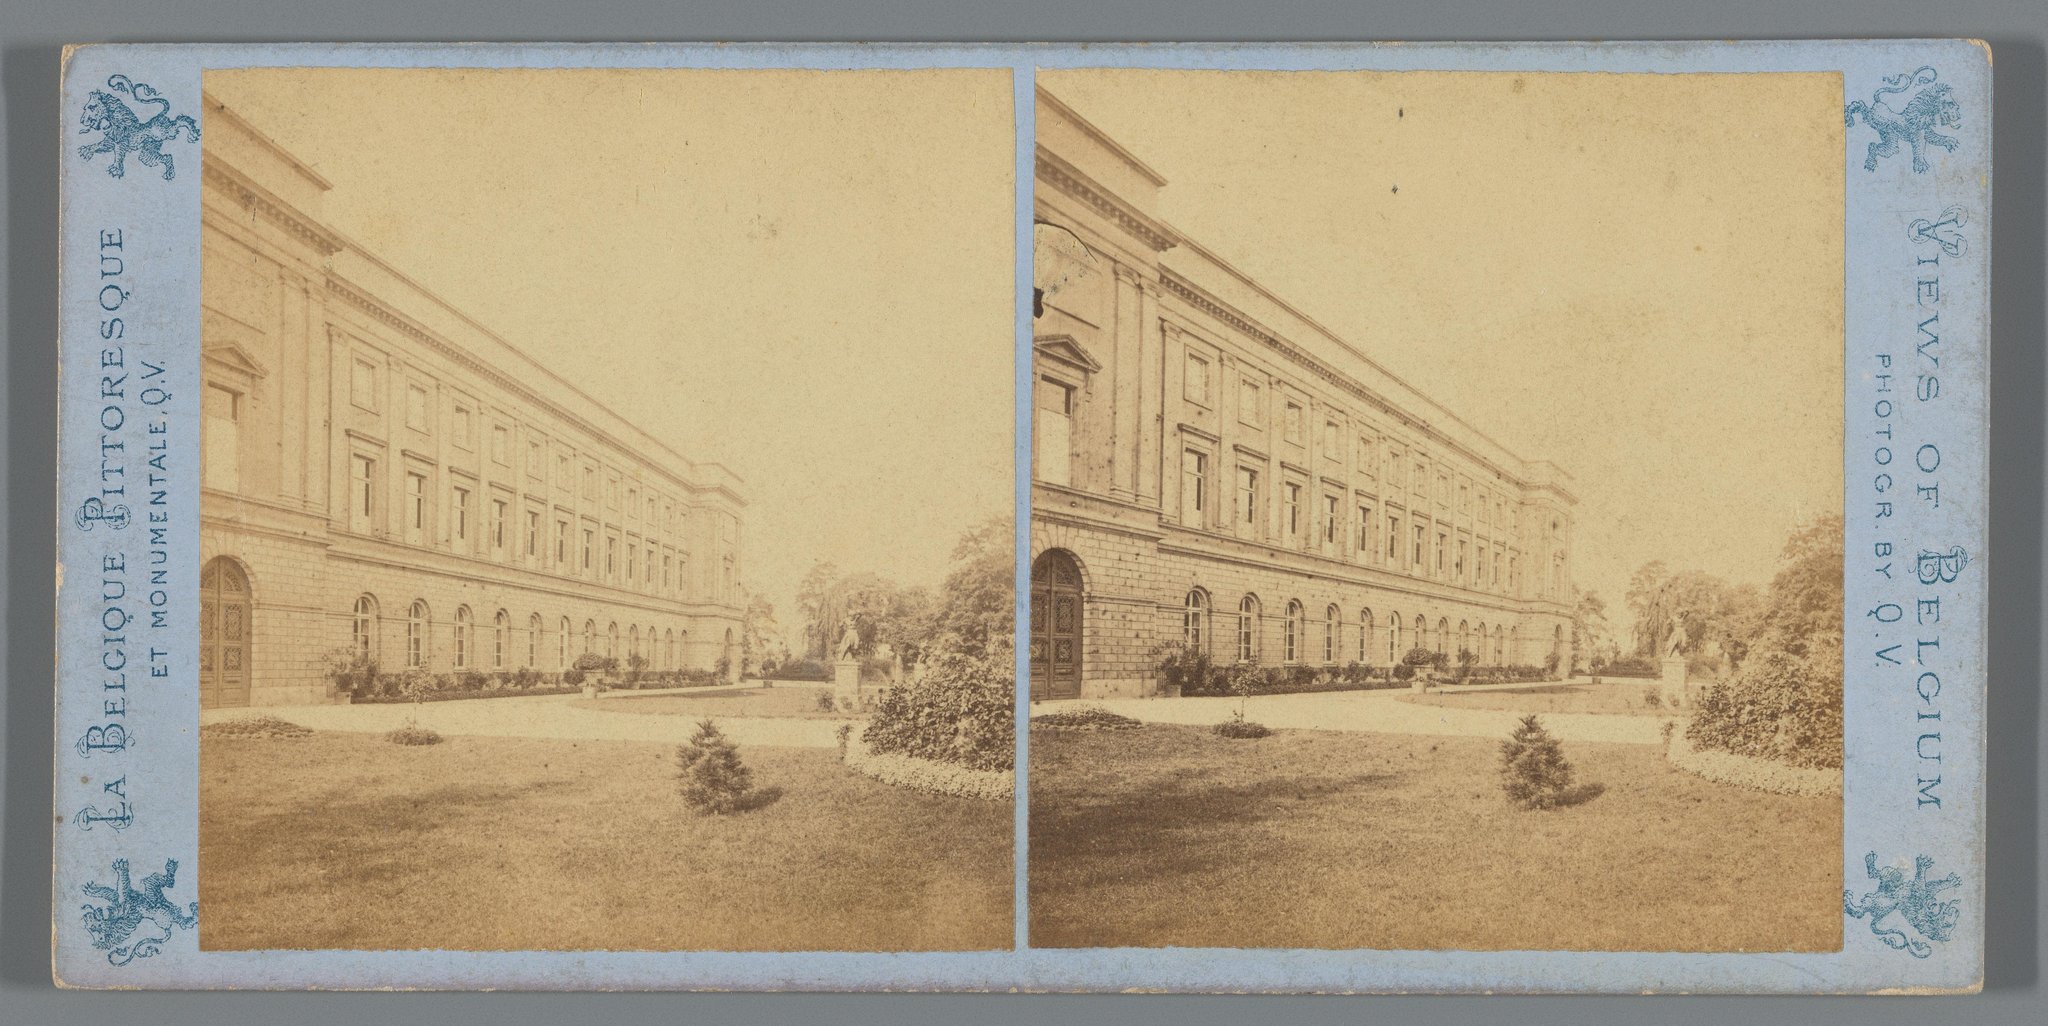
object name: stereograph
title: Academiënpaleis in Brussel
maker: jules hippolyte quéval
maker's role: publisher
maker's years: 1824-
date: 1866-1870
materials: cardboard, paper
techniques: albumen print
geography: brussels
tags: palace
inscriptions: number: ‘No 1624’